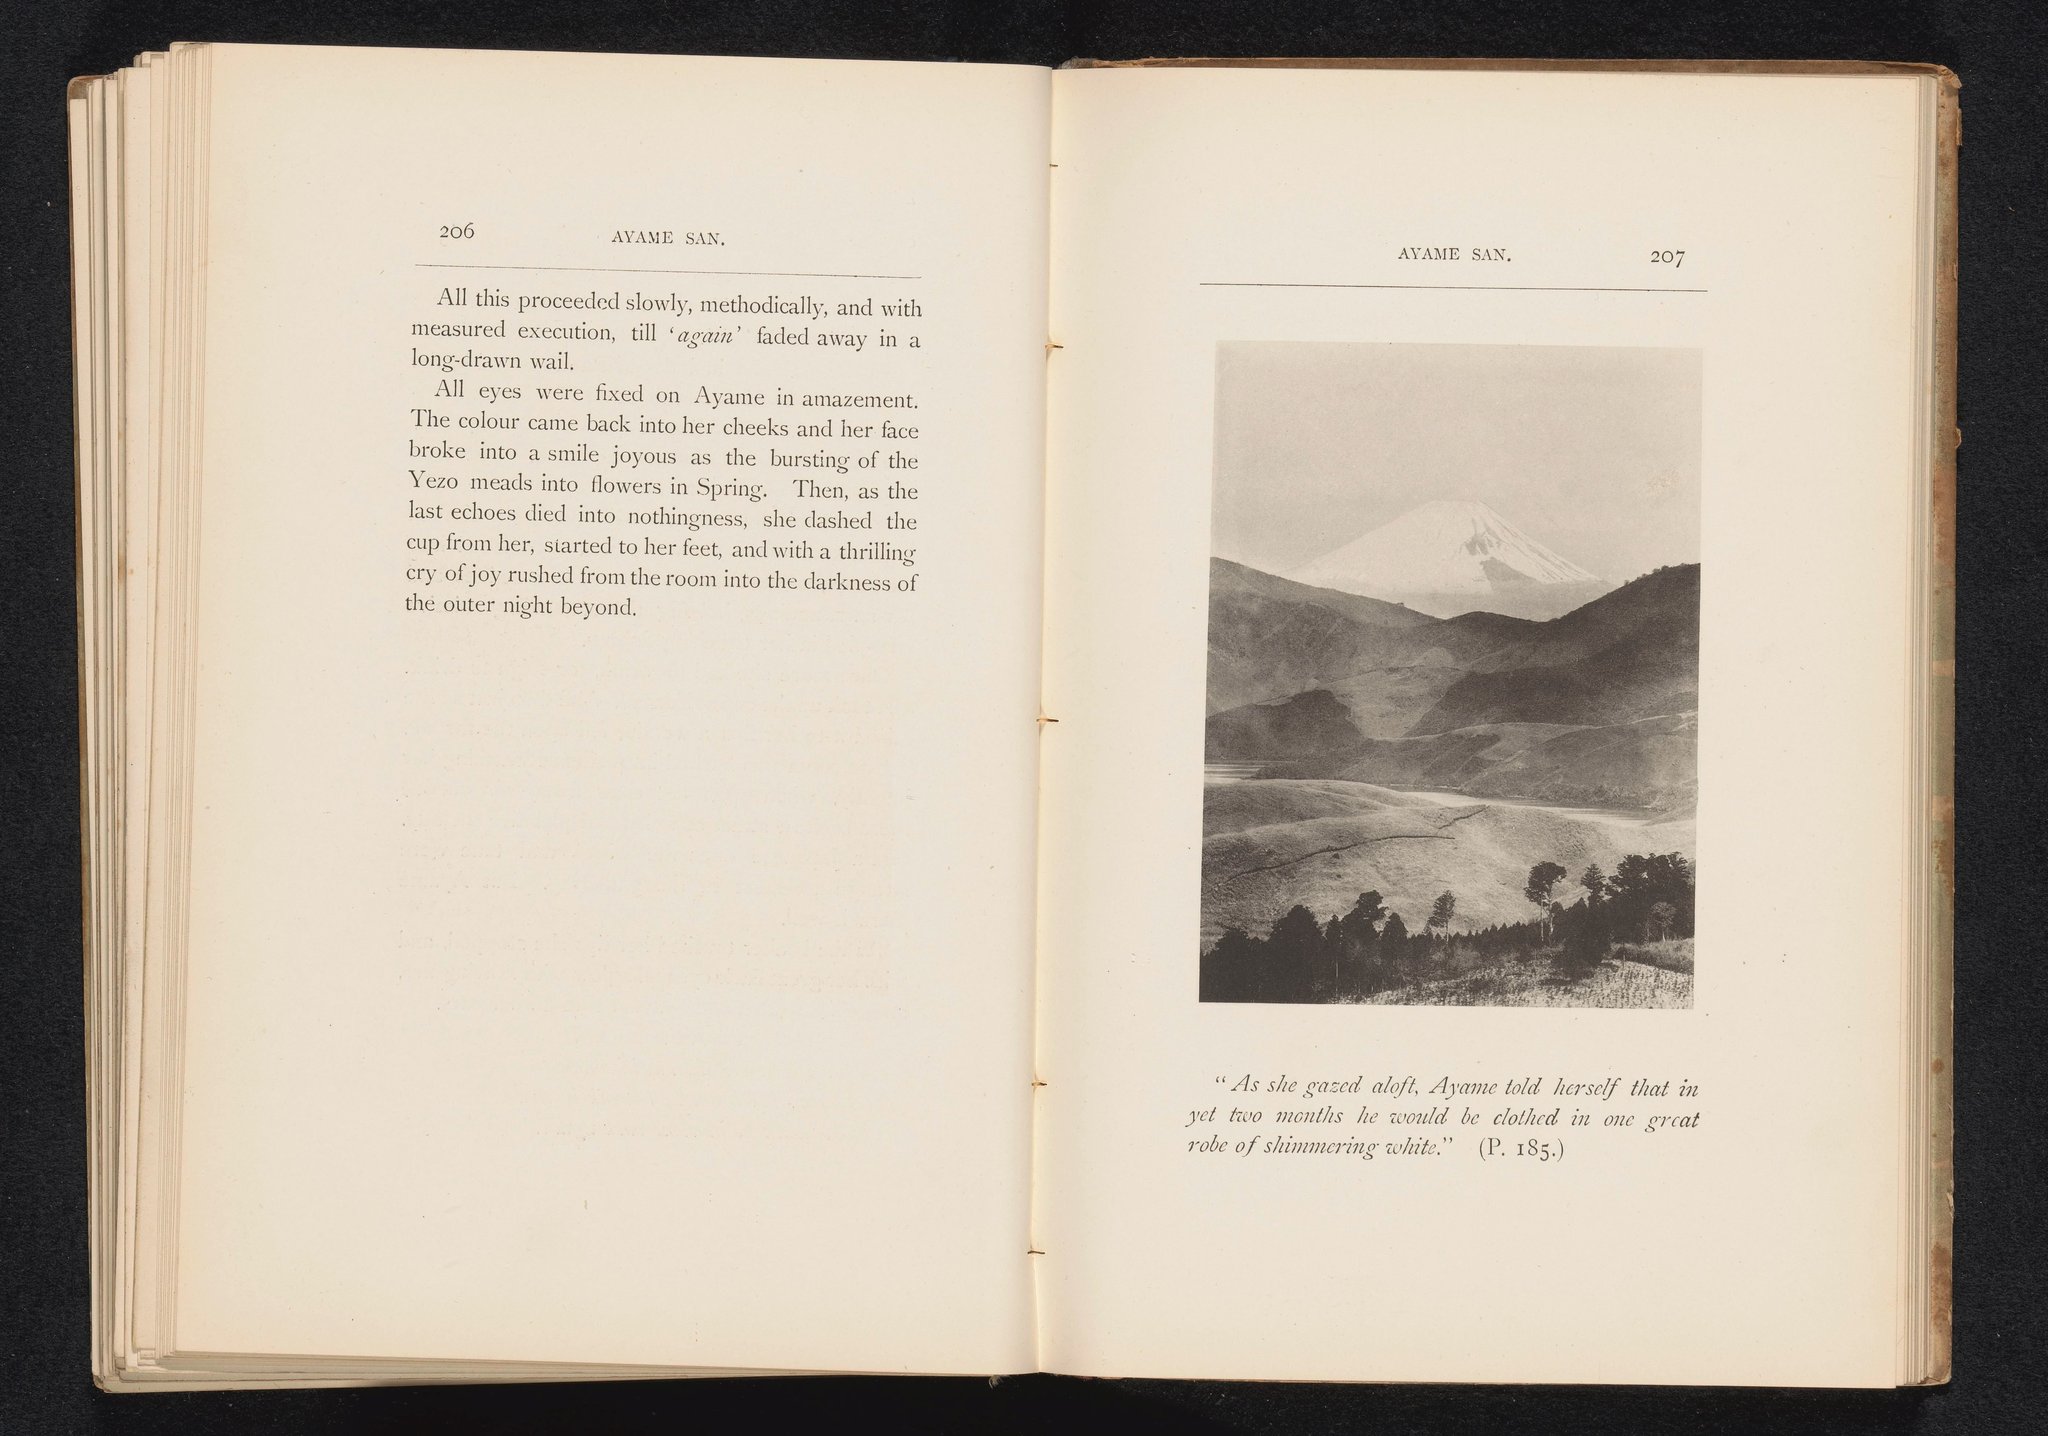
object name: photomechanical print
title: Gezicht op de berg Fuji te Japan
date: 1882-1892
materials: paper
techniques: photograph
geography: japan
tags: extinct volcano